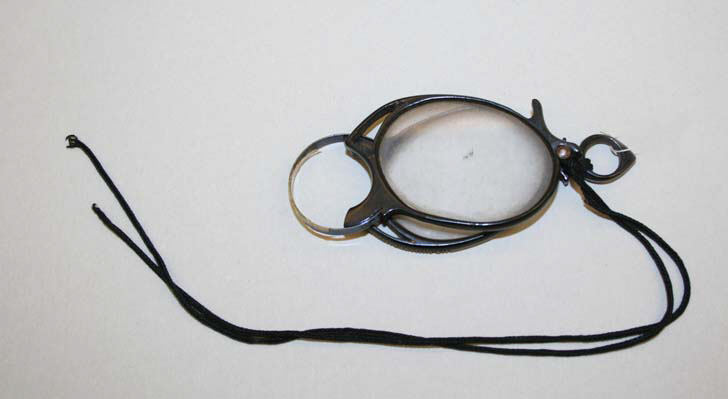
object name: pince nez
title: Pince-nez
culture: european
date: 1880-1889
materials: glass, horn